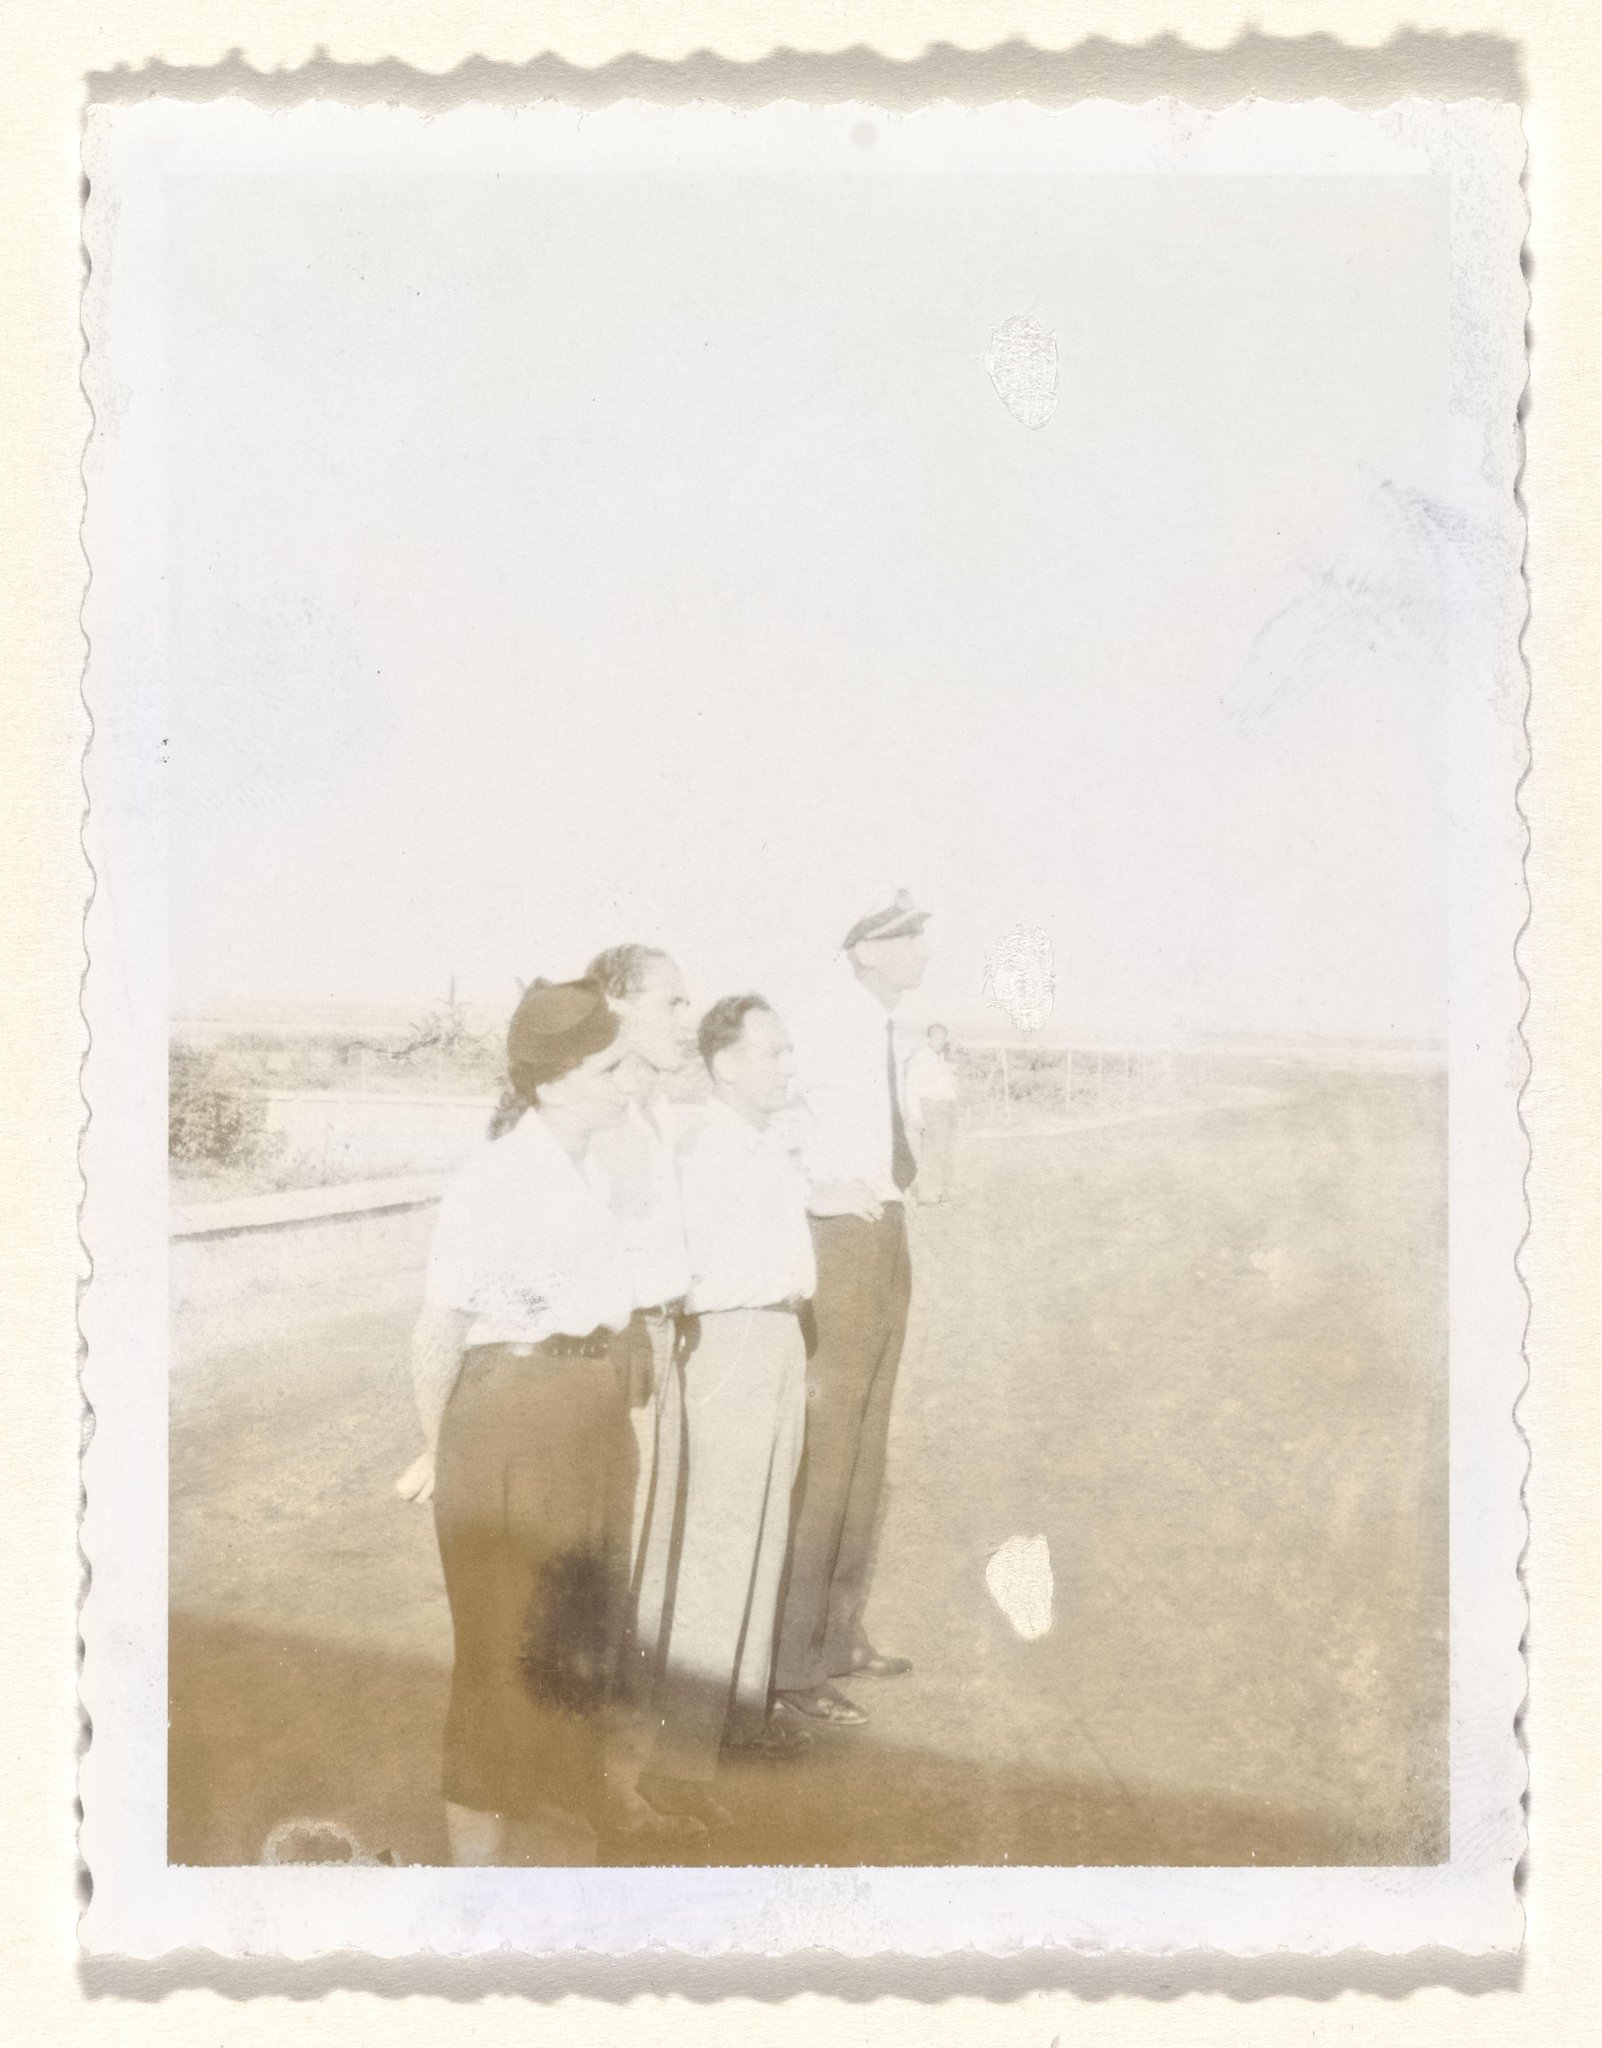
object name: photograph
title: Foto van Isabel Wachenheimer en drie onbekende personeelsleden van de KLM op een rij, overbelicht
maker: Anonymous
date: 1947-1955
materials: photographic support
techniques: gelatin silver print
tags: leiden, isabel wachenheimer-elon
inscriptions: number: ‘2130/34’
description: Foto van Isabel Wachenheimer en drie onbekende personeelsleden van de KLM op een rij, overbelicht.